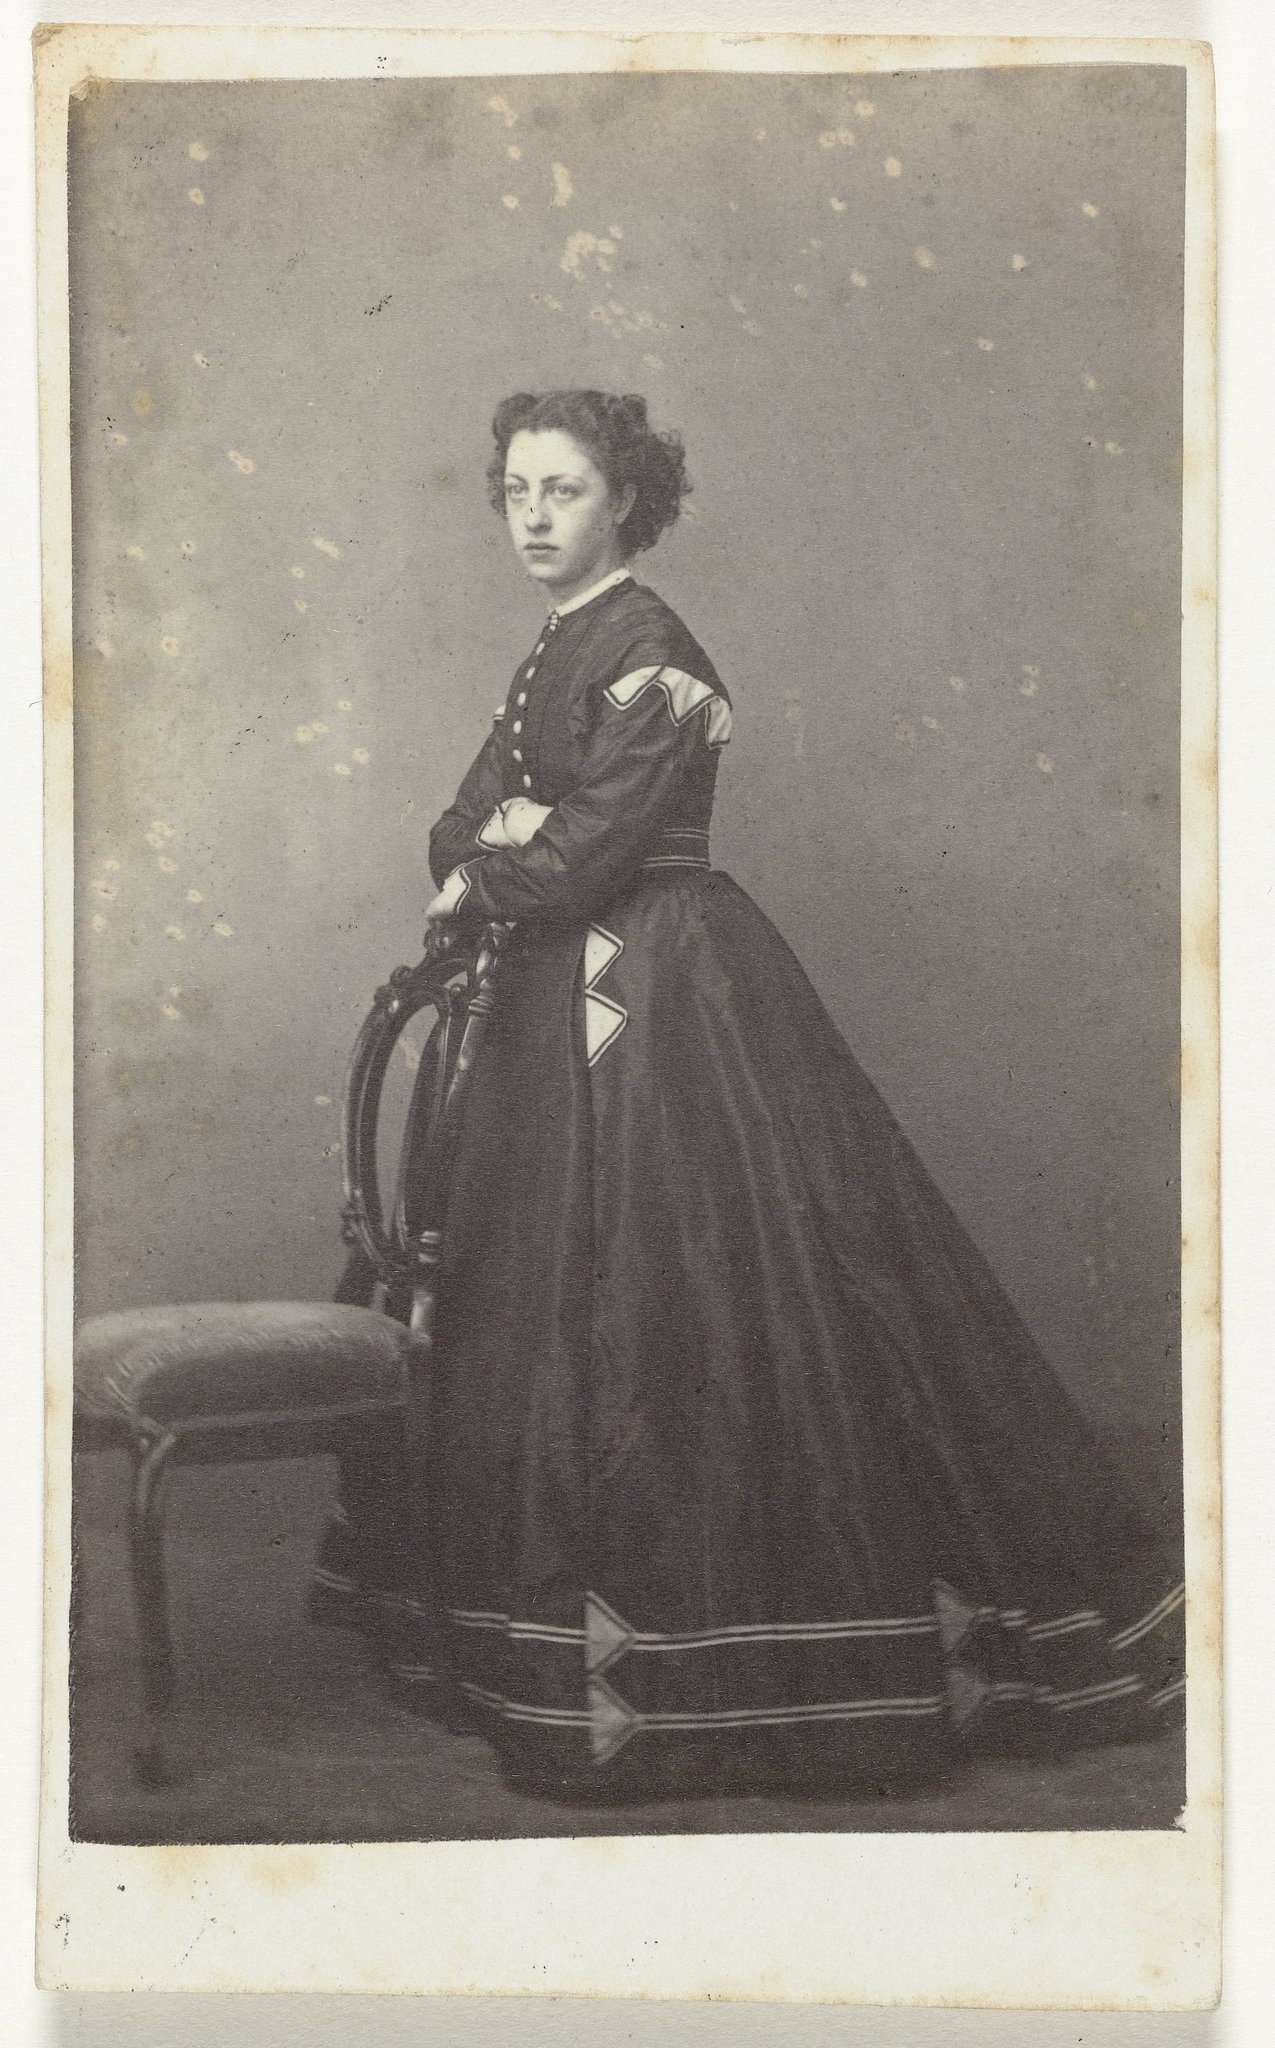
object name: photograph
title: Portret van een vrouw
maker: j. korsten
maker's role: fotograaf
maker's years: 1841-1878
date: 1860-1865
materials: cardboard, paper, photographic support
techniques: albumen print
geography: deventer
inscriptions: address: ‘J. Korsten/Kunstschilder/en/photographe/Middelburg’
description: Jonge vrouw in een japon versierd met driehoeken, staand achter een stoel, steunend op de rugleuning